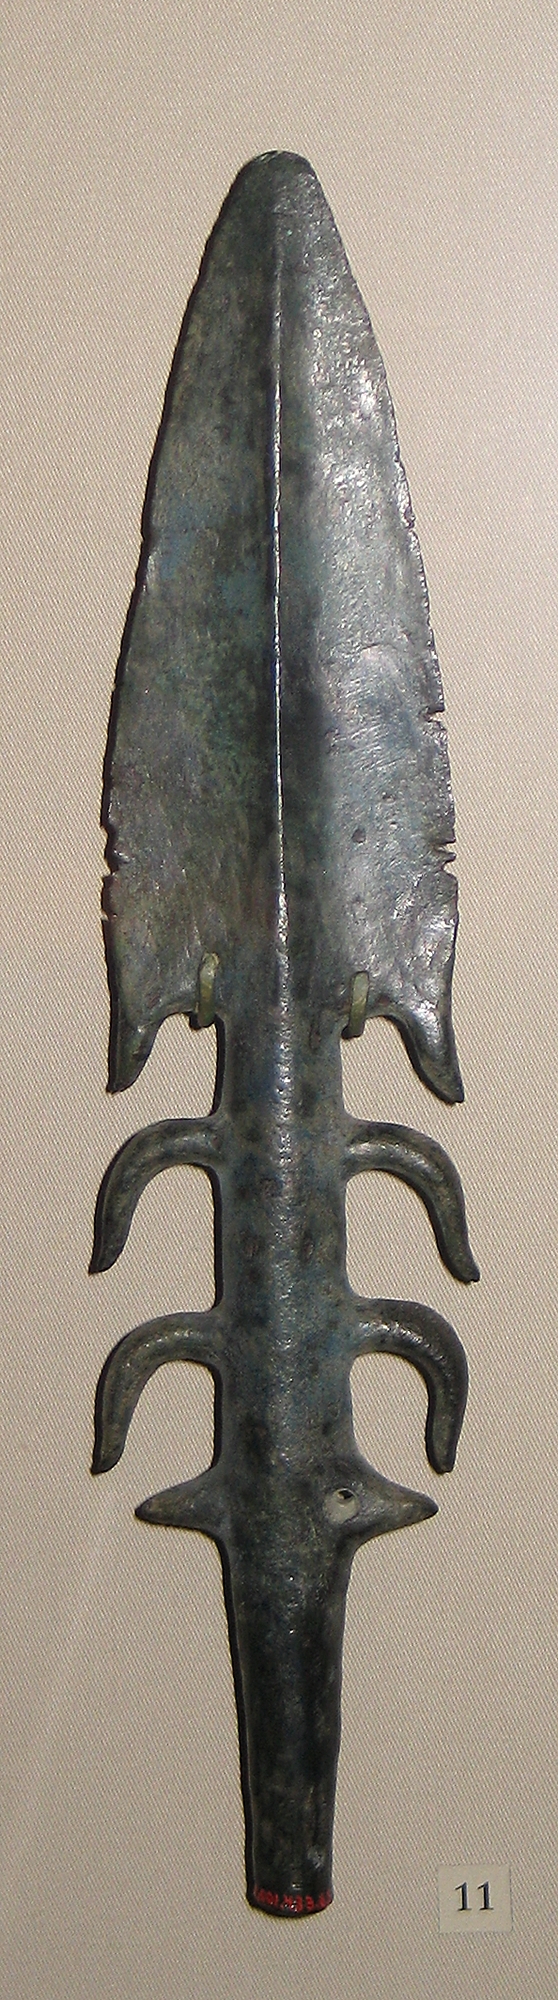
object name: harpoon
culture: indian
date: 1500-500 BCE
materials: copper